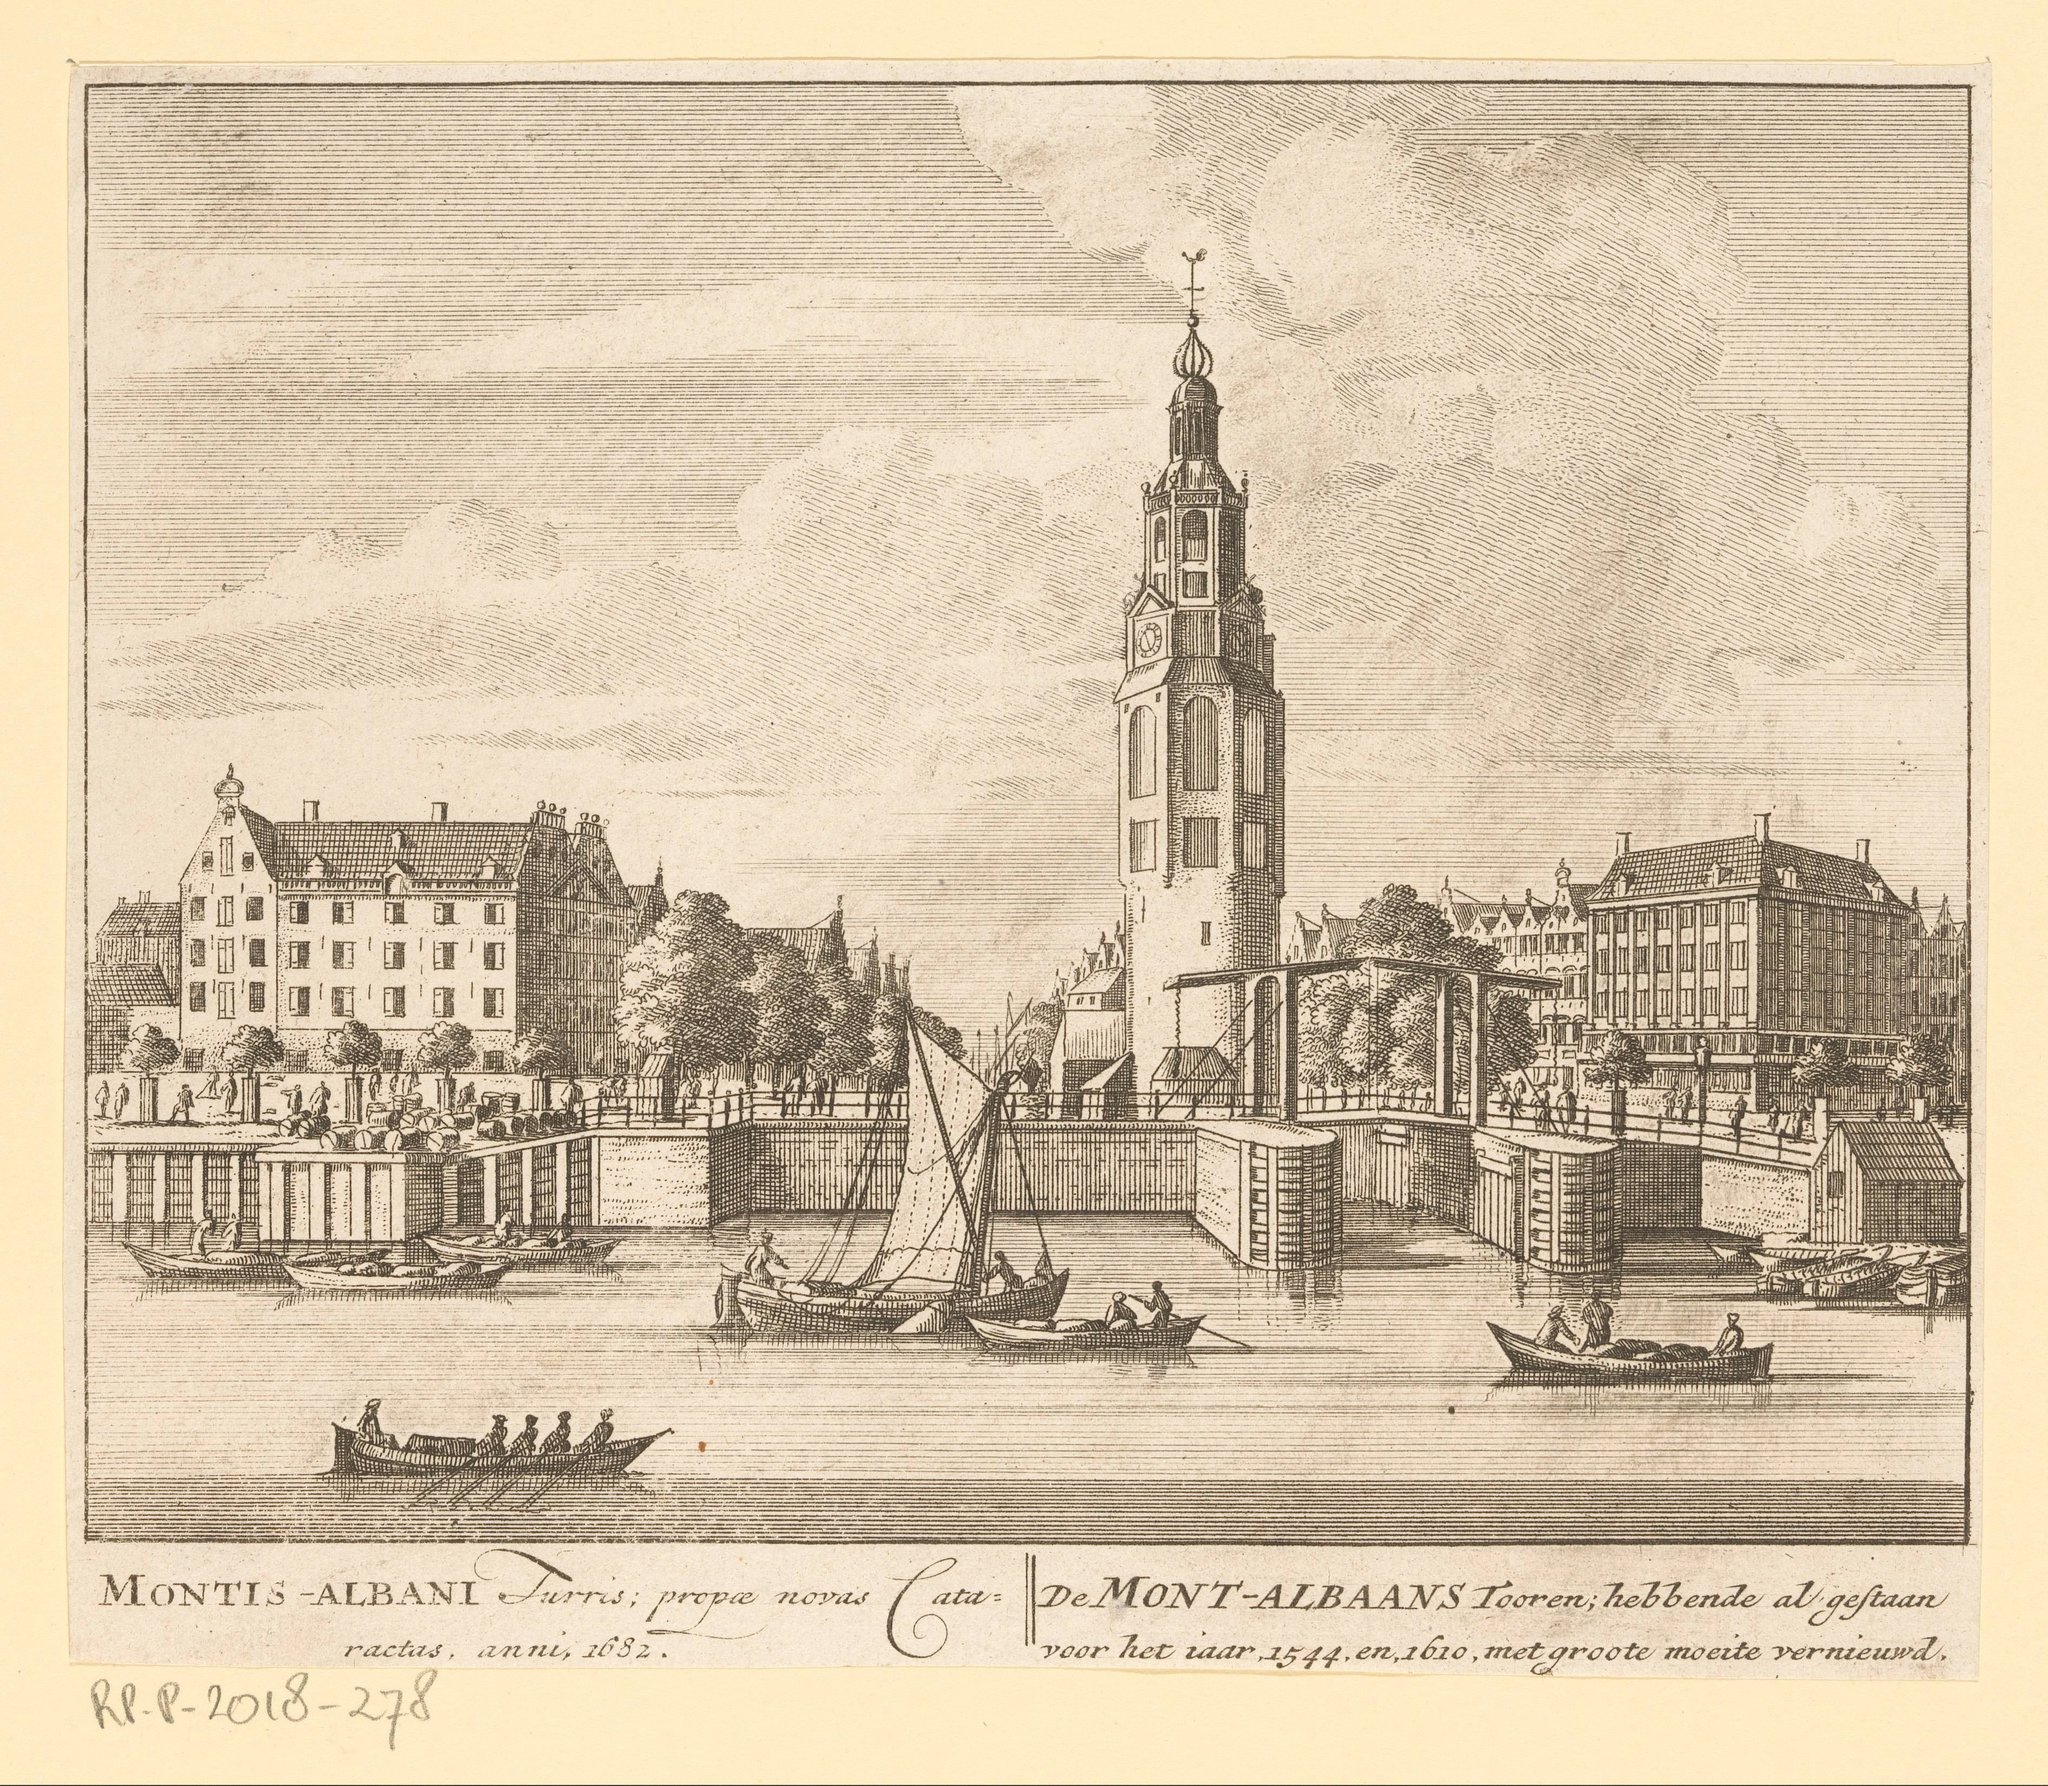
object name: print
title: Montis-Albani Turris; propae novas Cataractas, anni, 1682 / De Mont-Albaans Tooren; hebbende al gestaan voor het iaar, 1544, en, 1610, met groote moeite vernieuwd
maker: Anonymous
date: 1710-1711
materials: paper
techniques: engraving, etching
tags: bridge in city across river, canal, etc. (+ city(-scape) with figures, staffage), tower, clock tower ~ monumental adornment, towers ~ fortified city, canals, waters (in city) (+ city(-scape) with figures, staffage), street (+ city(-scape) with figures, staffage)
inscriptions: collector's mark: Lugt 2228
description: Genummerde staat van prent ook gebruikt in: 100 Afbeeldinge der voornaamste gebouwen van Amsterdam. Amsterdam, Pieter Schenk (I), s.a. [1710-1711]. En in: 100 Afbeeldinge der voornaamste gebouwen van Amsterdam. Amsterdam, Barent Greve, s.a. [1757-1766].* *In de tweede uitgave, uitgegeven door Barent Greve, is alleen de titelprent aangepast. De overige prenten zijn onveranderd gebleven.